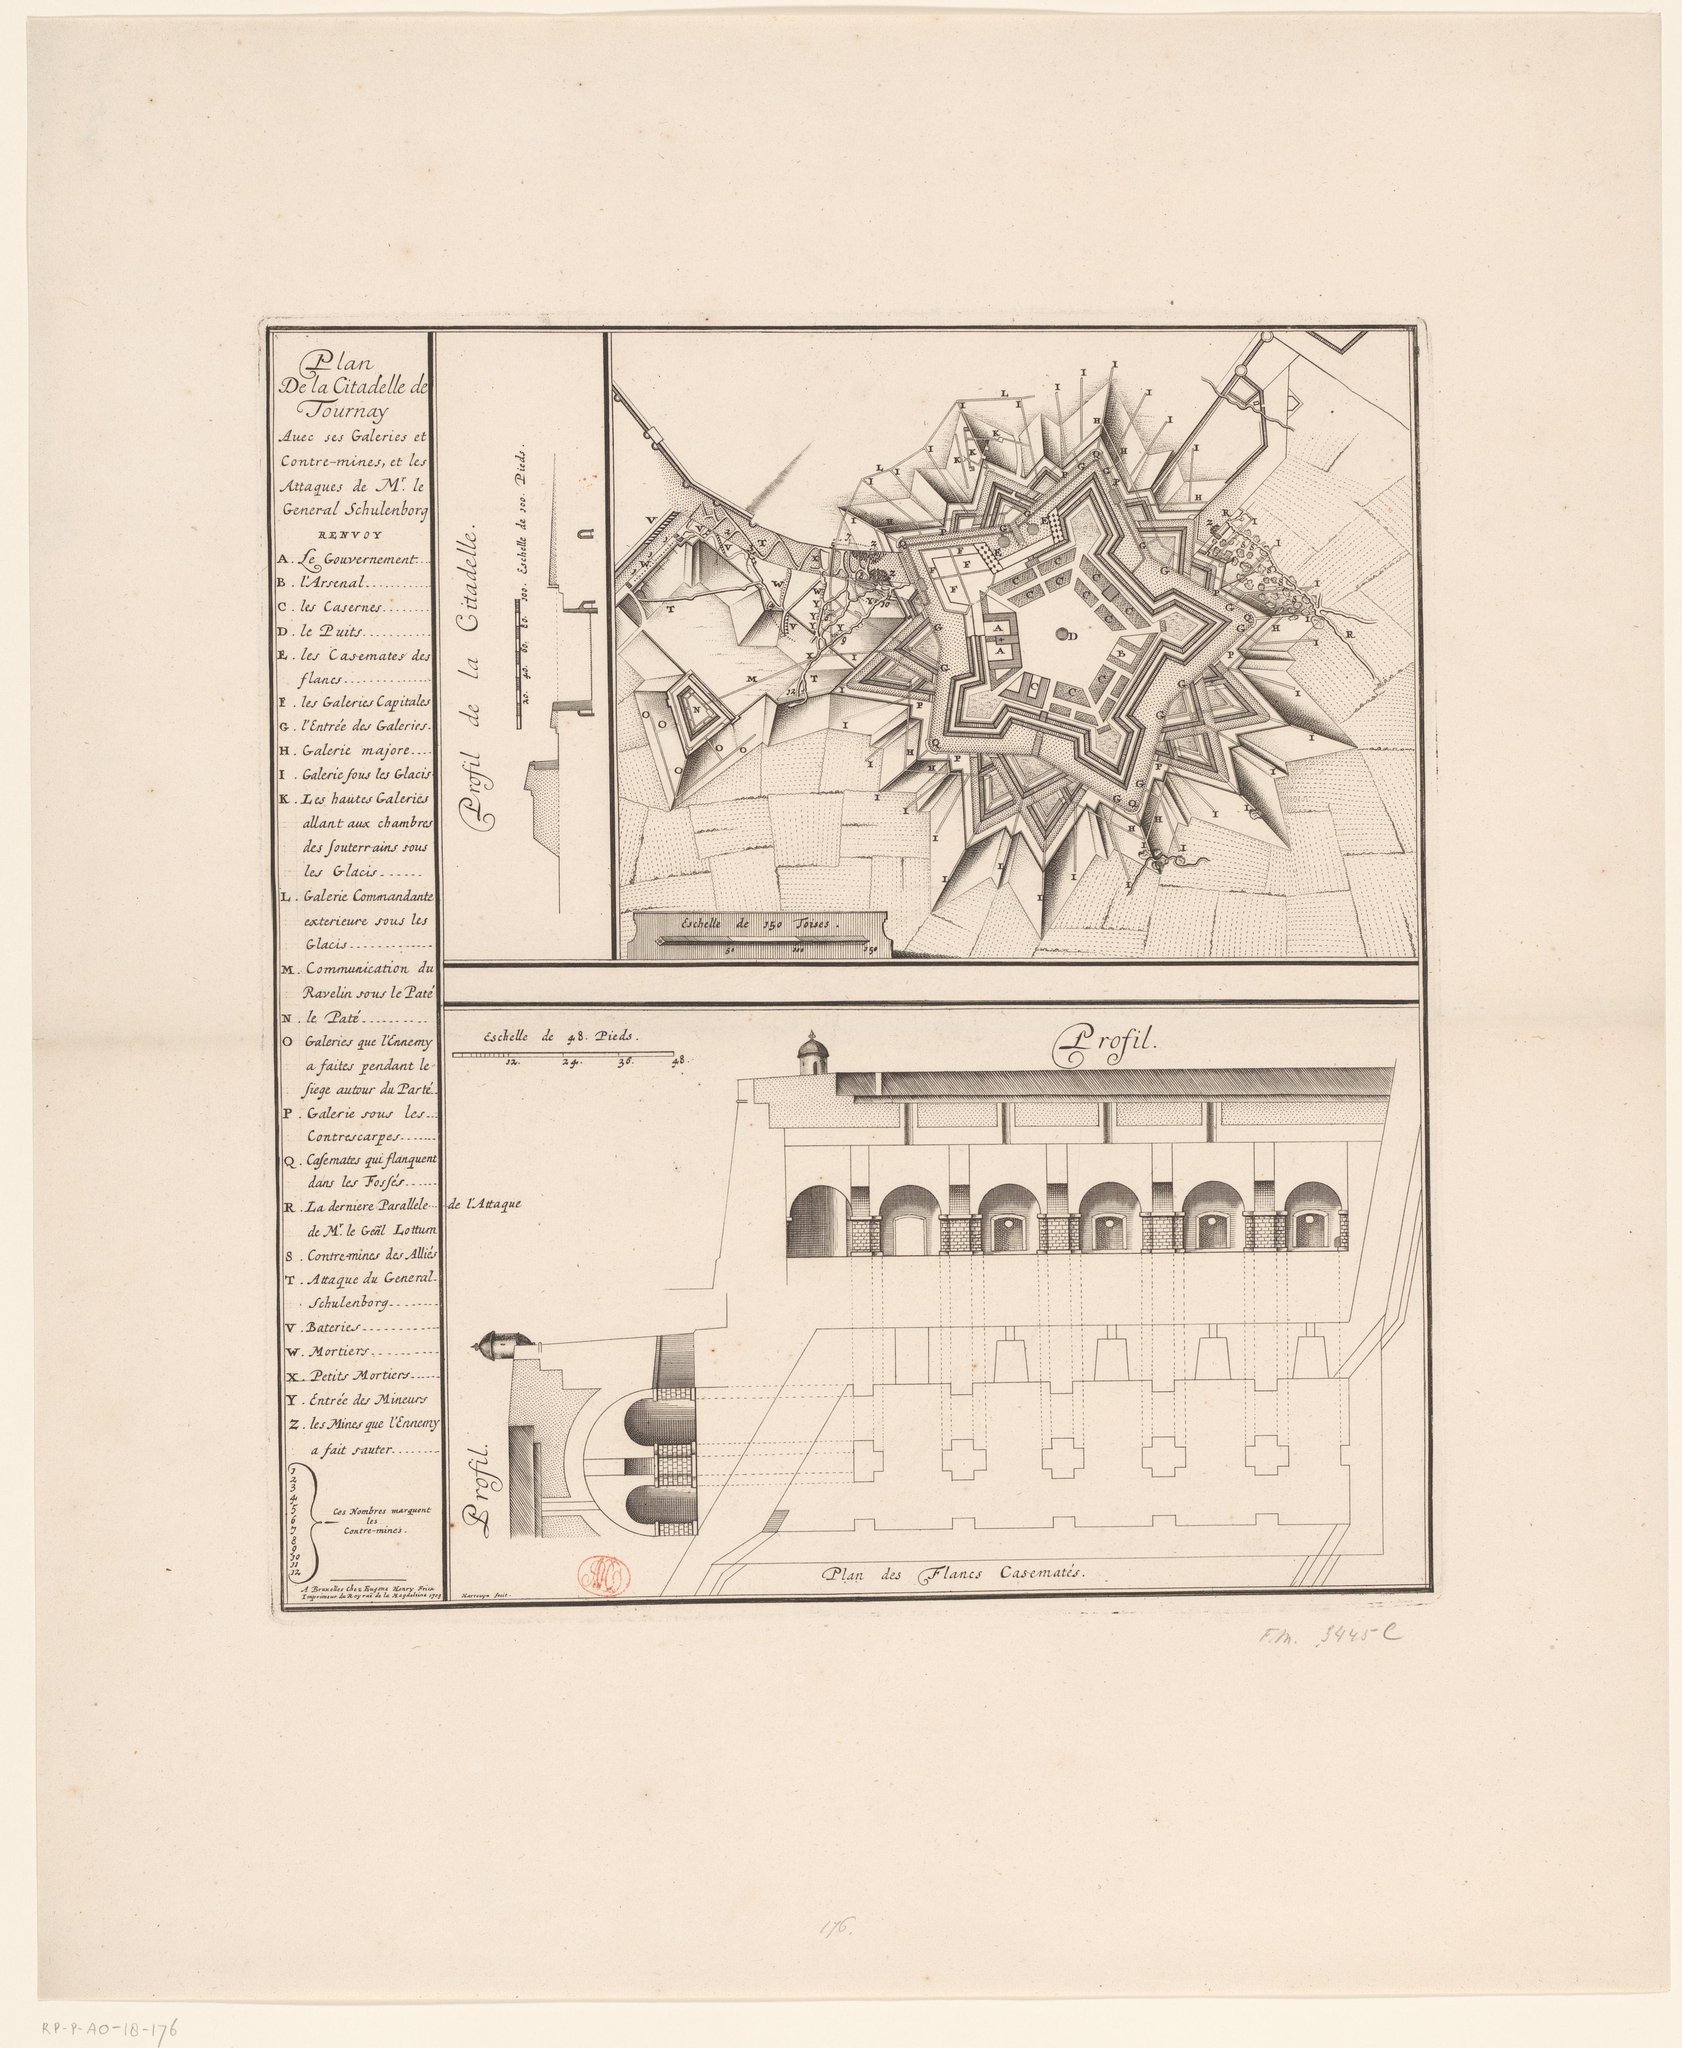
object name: area plan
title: Plattegrond en doorsnede van de citadel van Tournai, 1709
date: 1709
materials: paper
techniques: engraving, etching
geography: brussels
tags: fortress, maps of cities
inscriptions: collector's mark: Lugt 2228, collector's mark: Lugt 195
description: Plattegrond en doorsnede van de citadel van Tournai (Doornik), belegerd door de Geallieerden vanaf 29 juni en ingenomen op 2 september 1709. Links de legenda A-Z in het Frans.